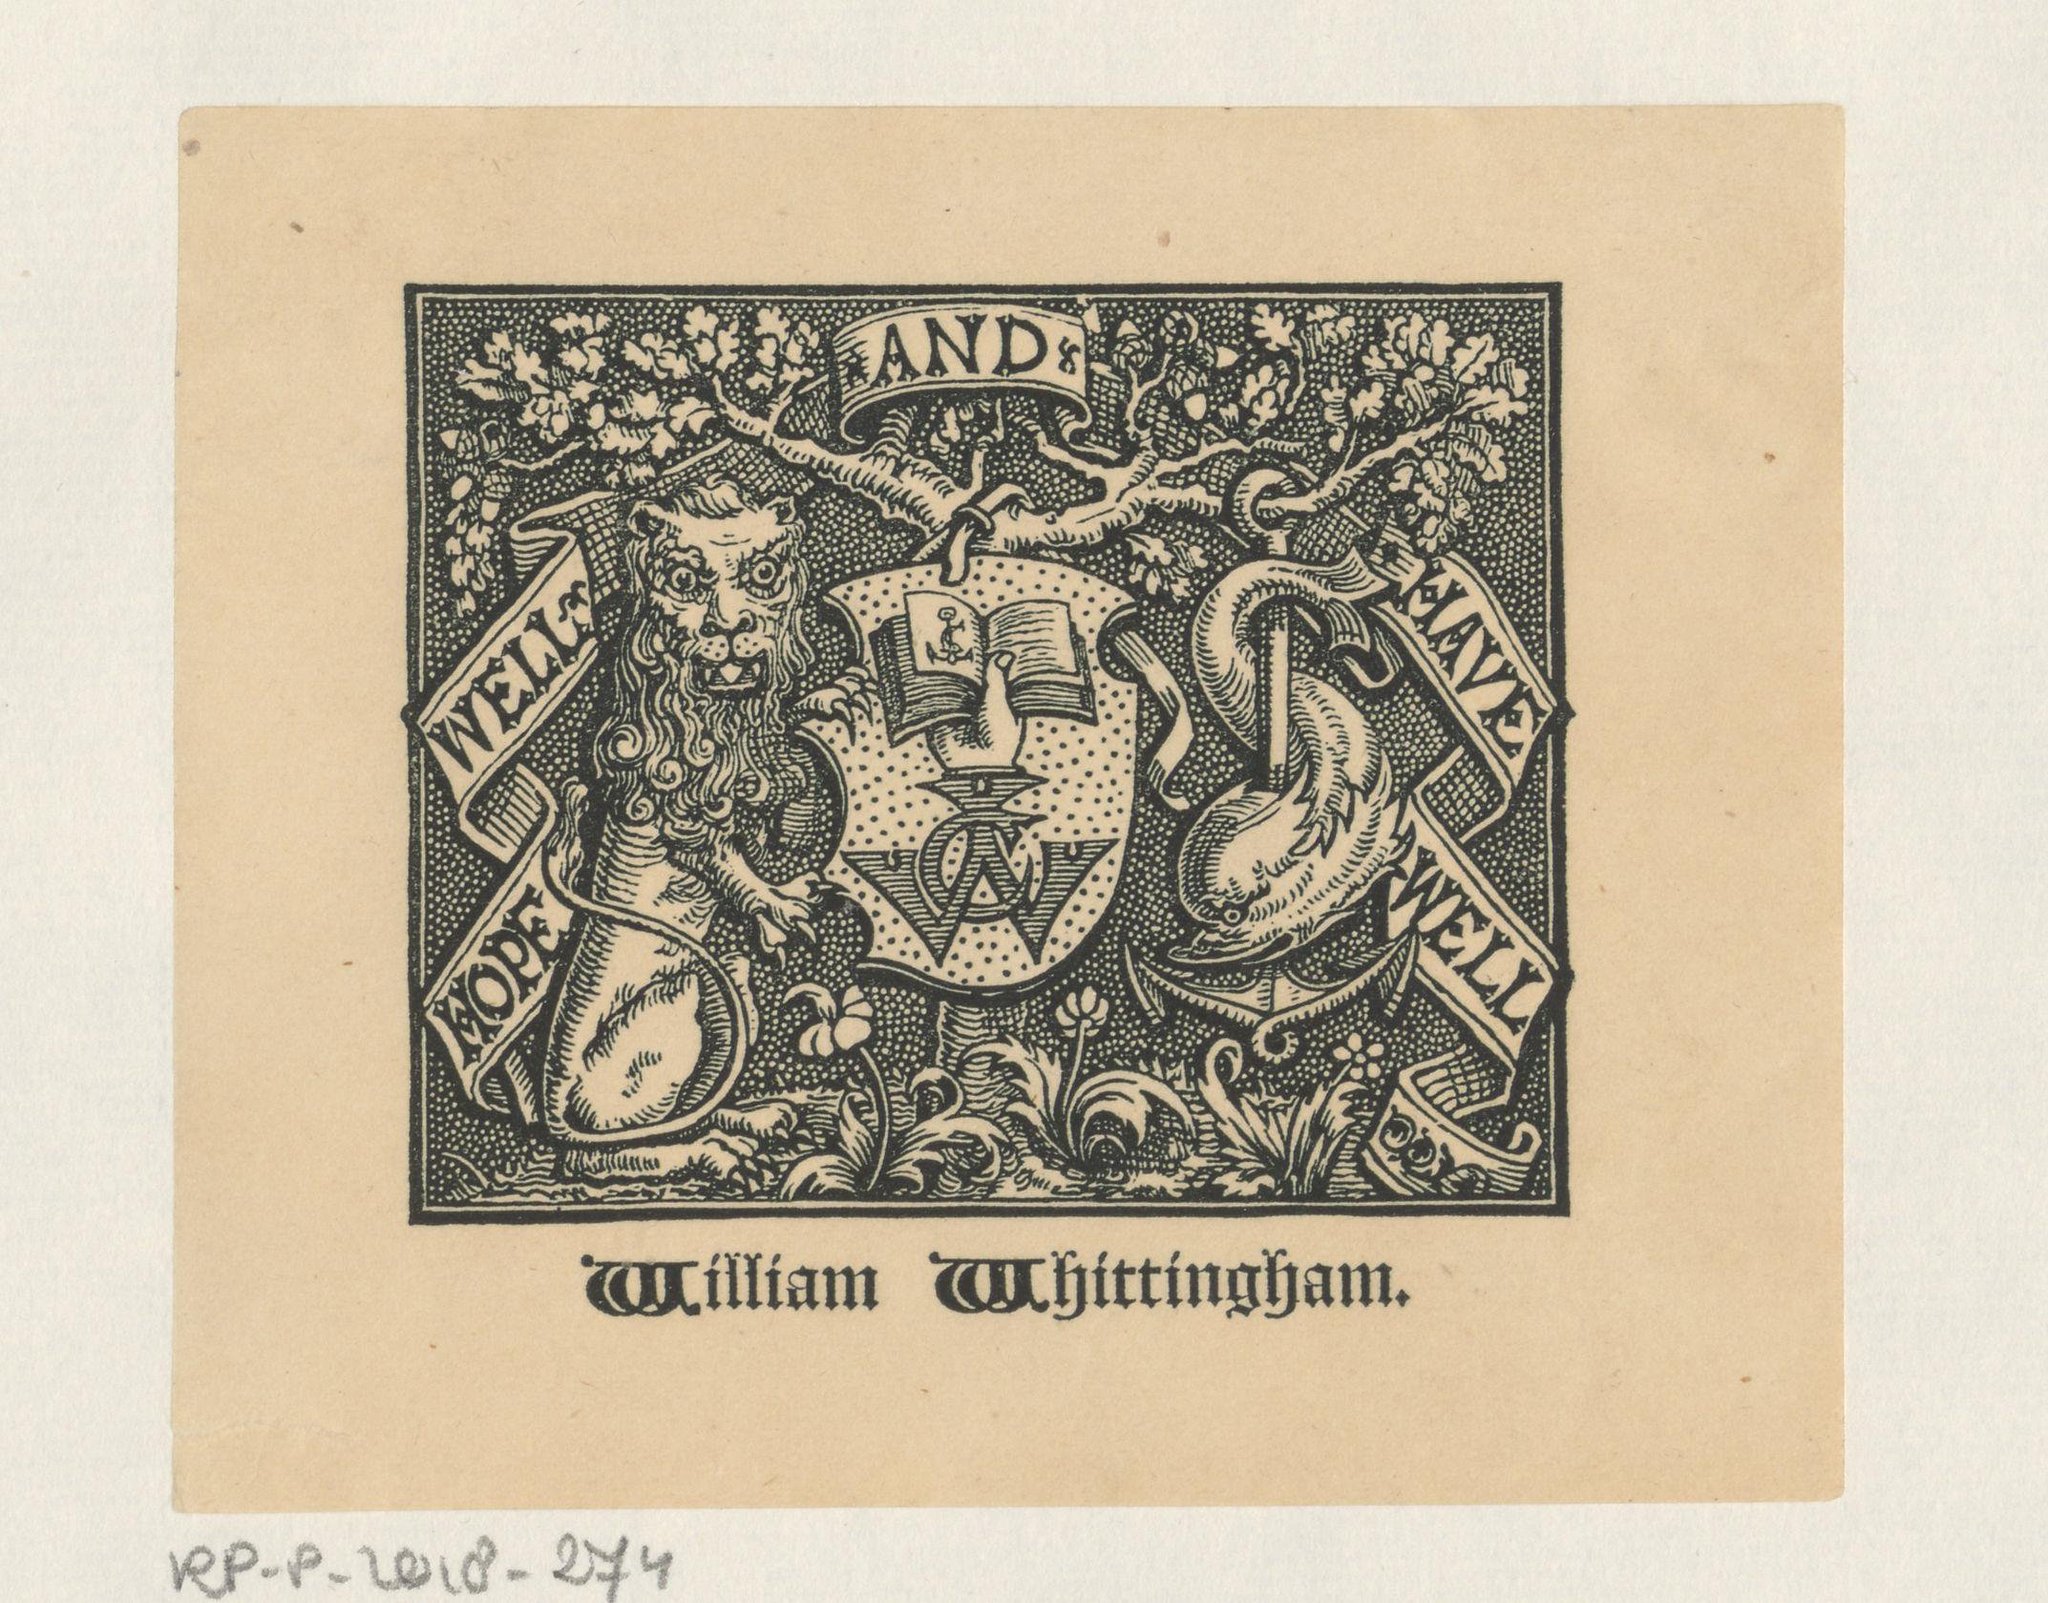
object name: bookplate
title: Hole well and have well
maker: Anonymous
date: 1885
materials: paper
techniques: printing block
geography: england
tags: trees: oak, fishes, book, beasts of prey, predatory animals: lion, armorial bearing, heraldry